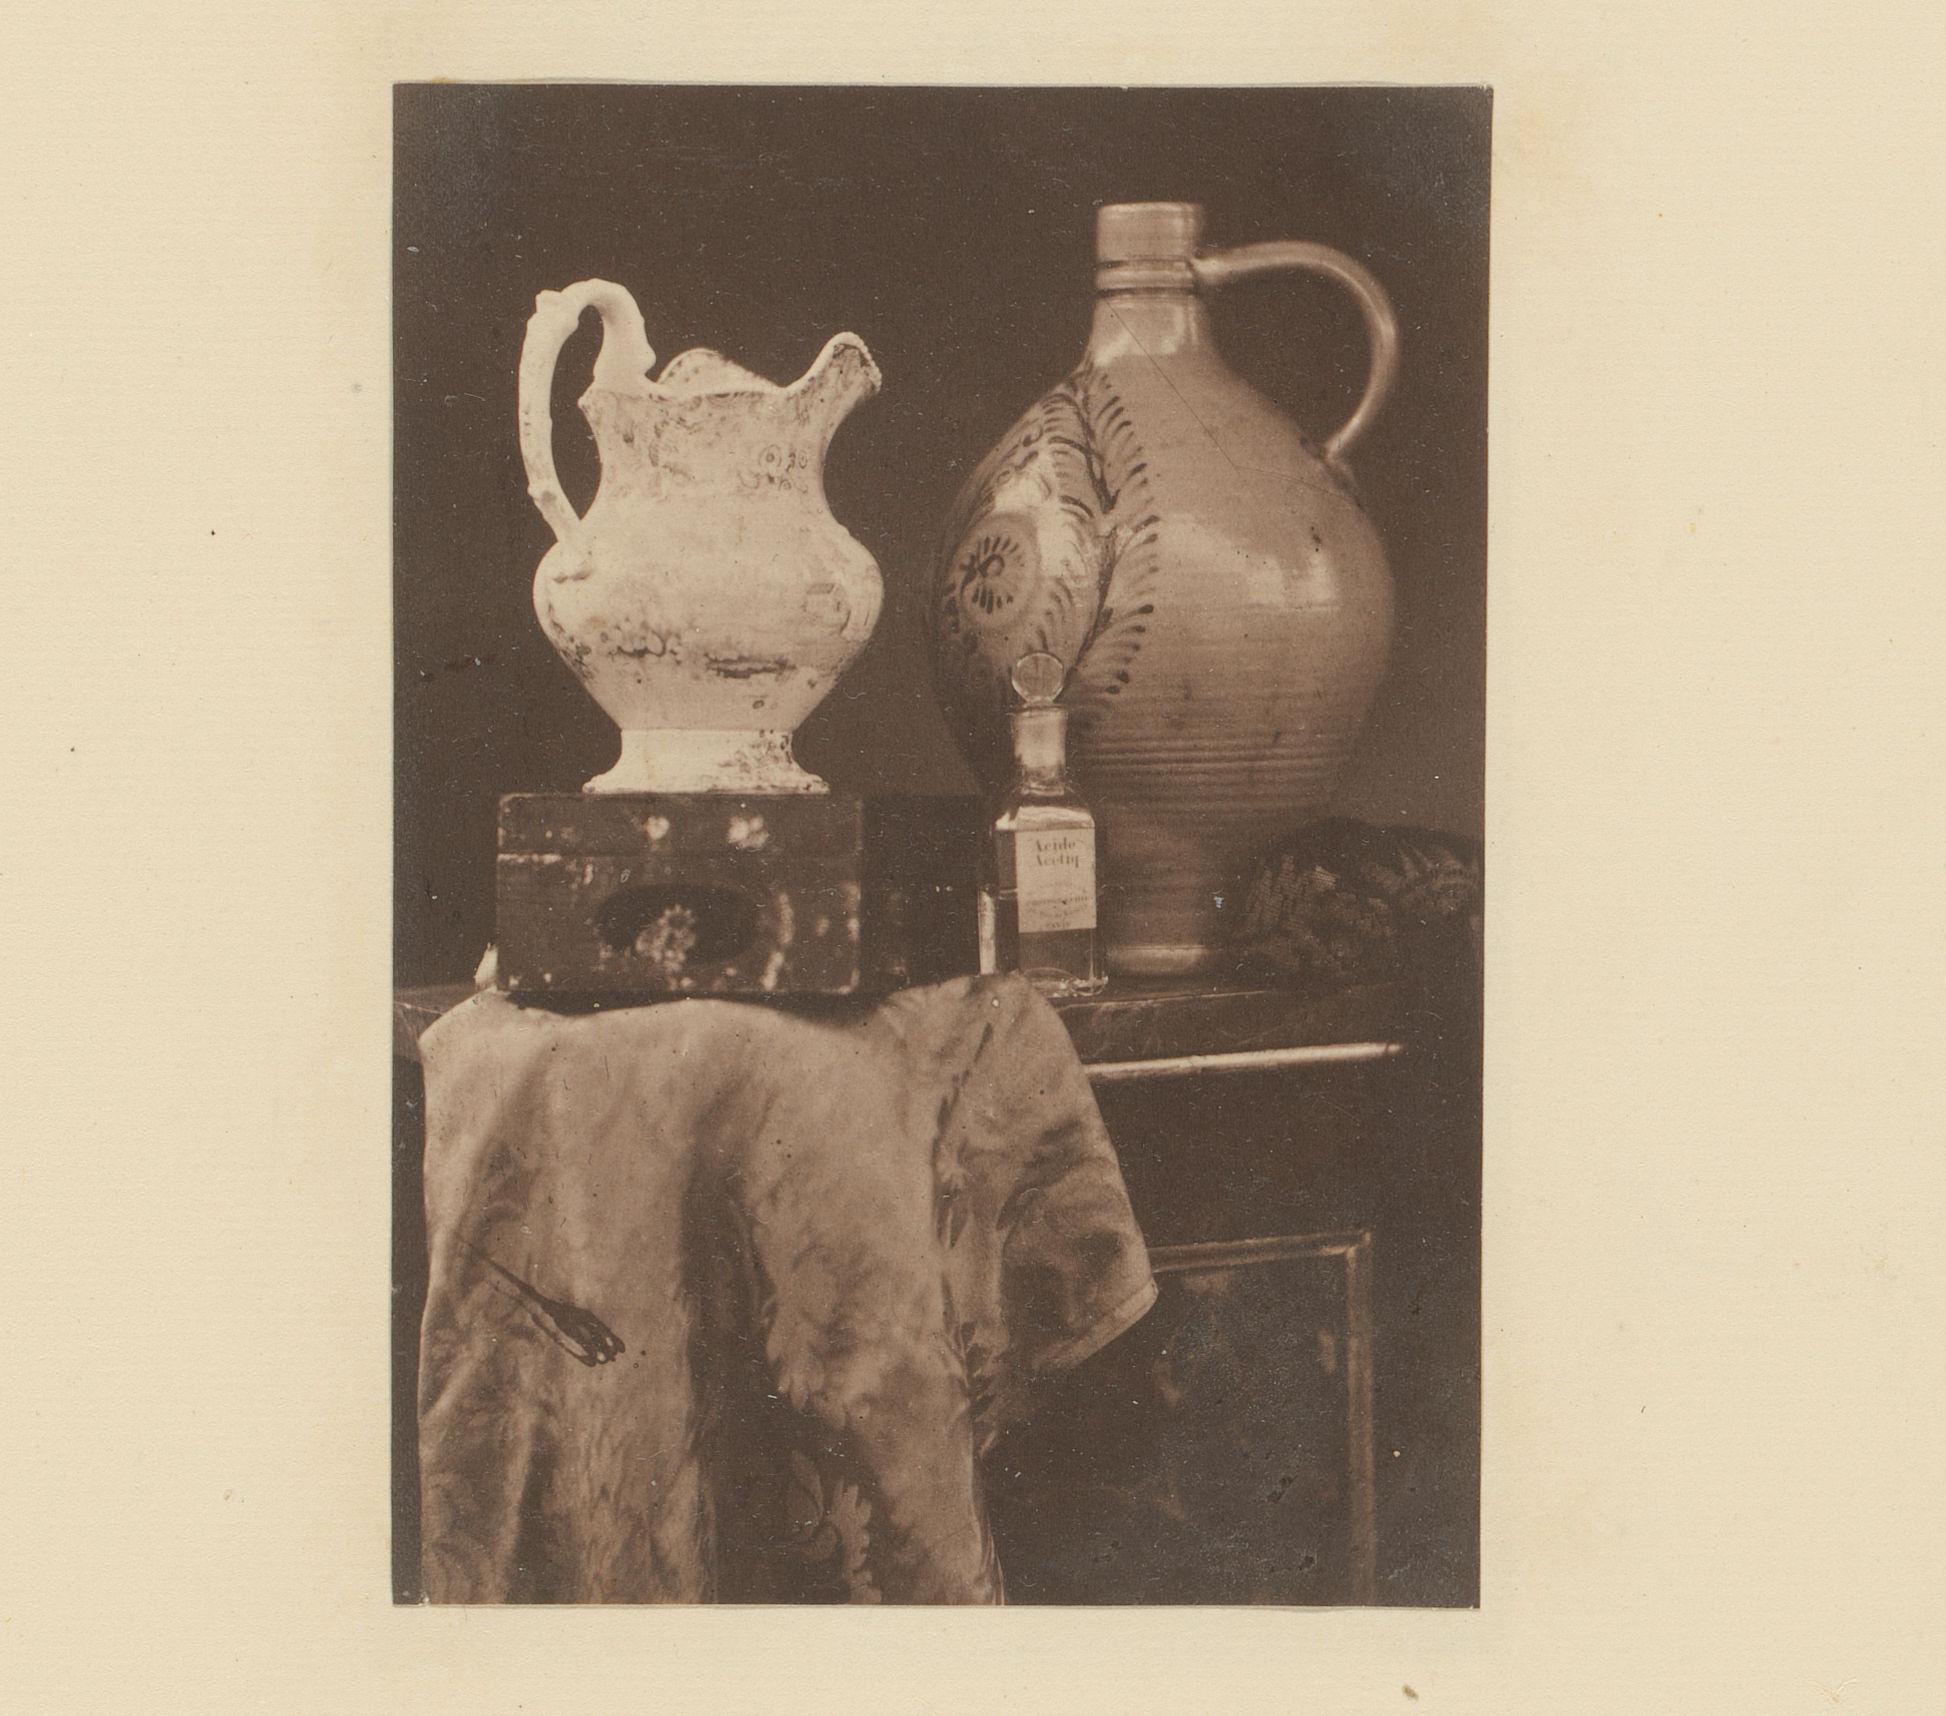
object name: photograph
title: Stilleven met Engelse roomkan, Westerwaldkruik en een flesje Acide Acétique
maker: eduard isaac asser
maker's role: amateurfotograaf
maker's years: 1809-1894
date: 1852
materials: cardboard, paper, photographic support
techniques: salted paper print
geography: amsterdam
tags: still life of miscellaneous objects